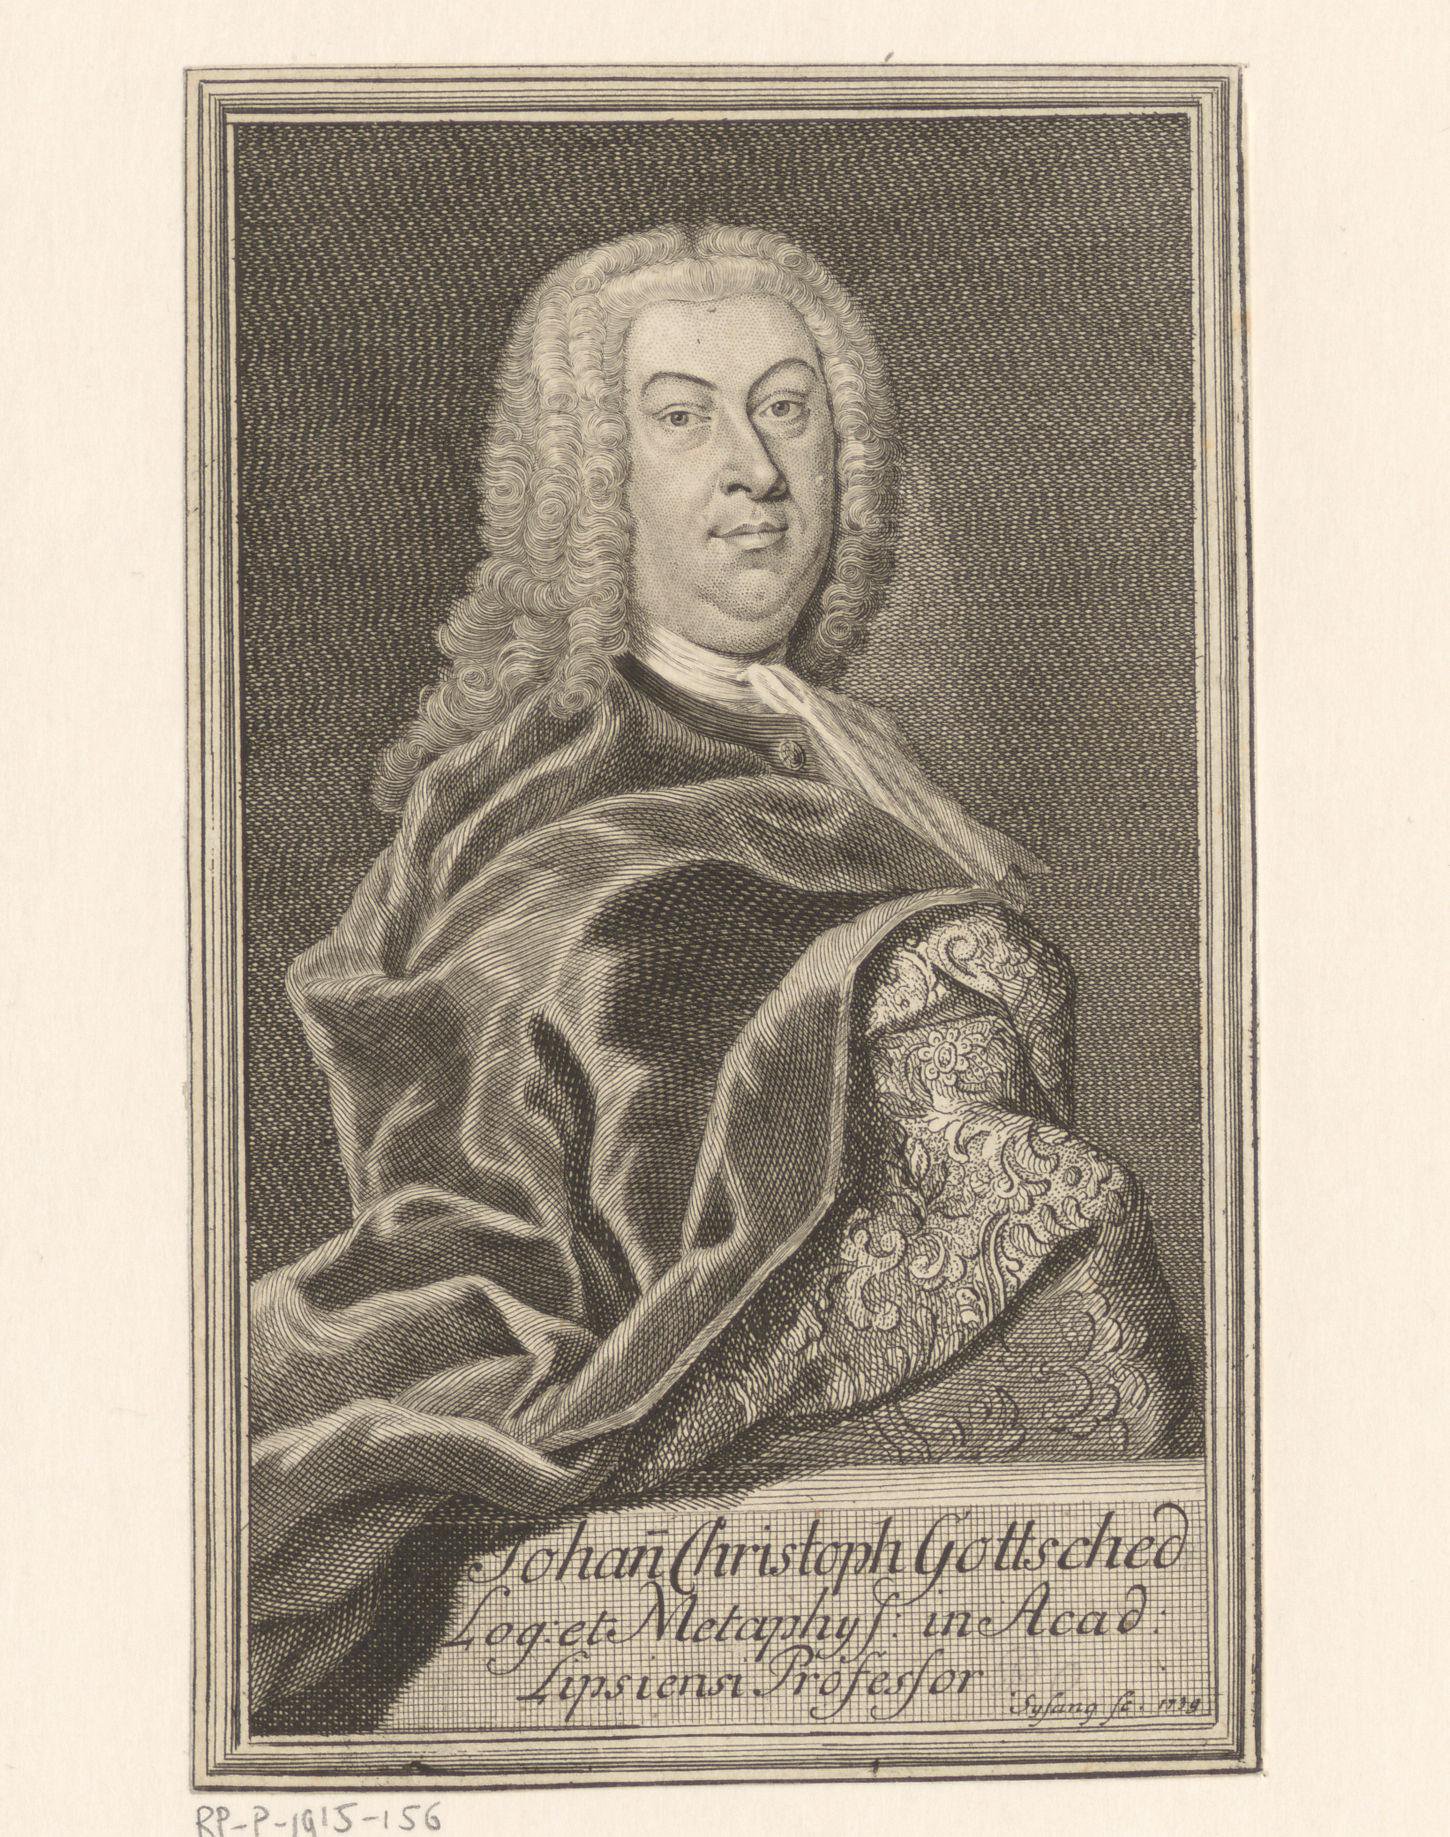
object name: print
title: Portret van Johann Christoph Gottsched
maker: johann christoph sysang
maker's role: print maker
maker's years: 1703-1757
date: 1739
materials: paper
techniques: engraving, etching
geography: leipzig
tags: historical persons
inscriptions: collector's mark: Lugt 2228